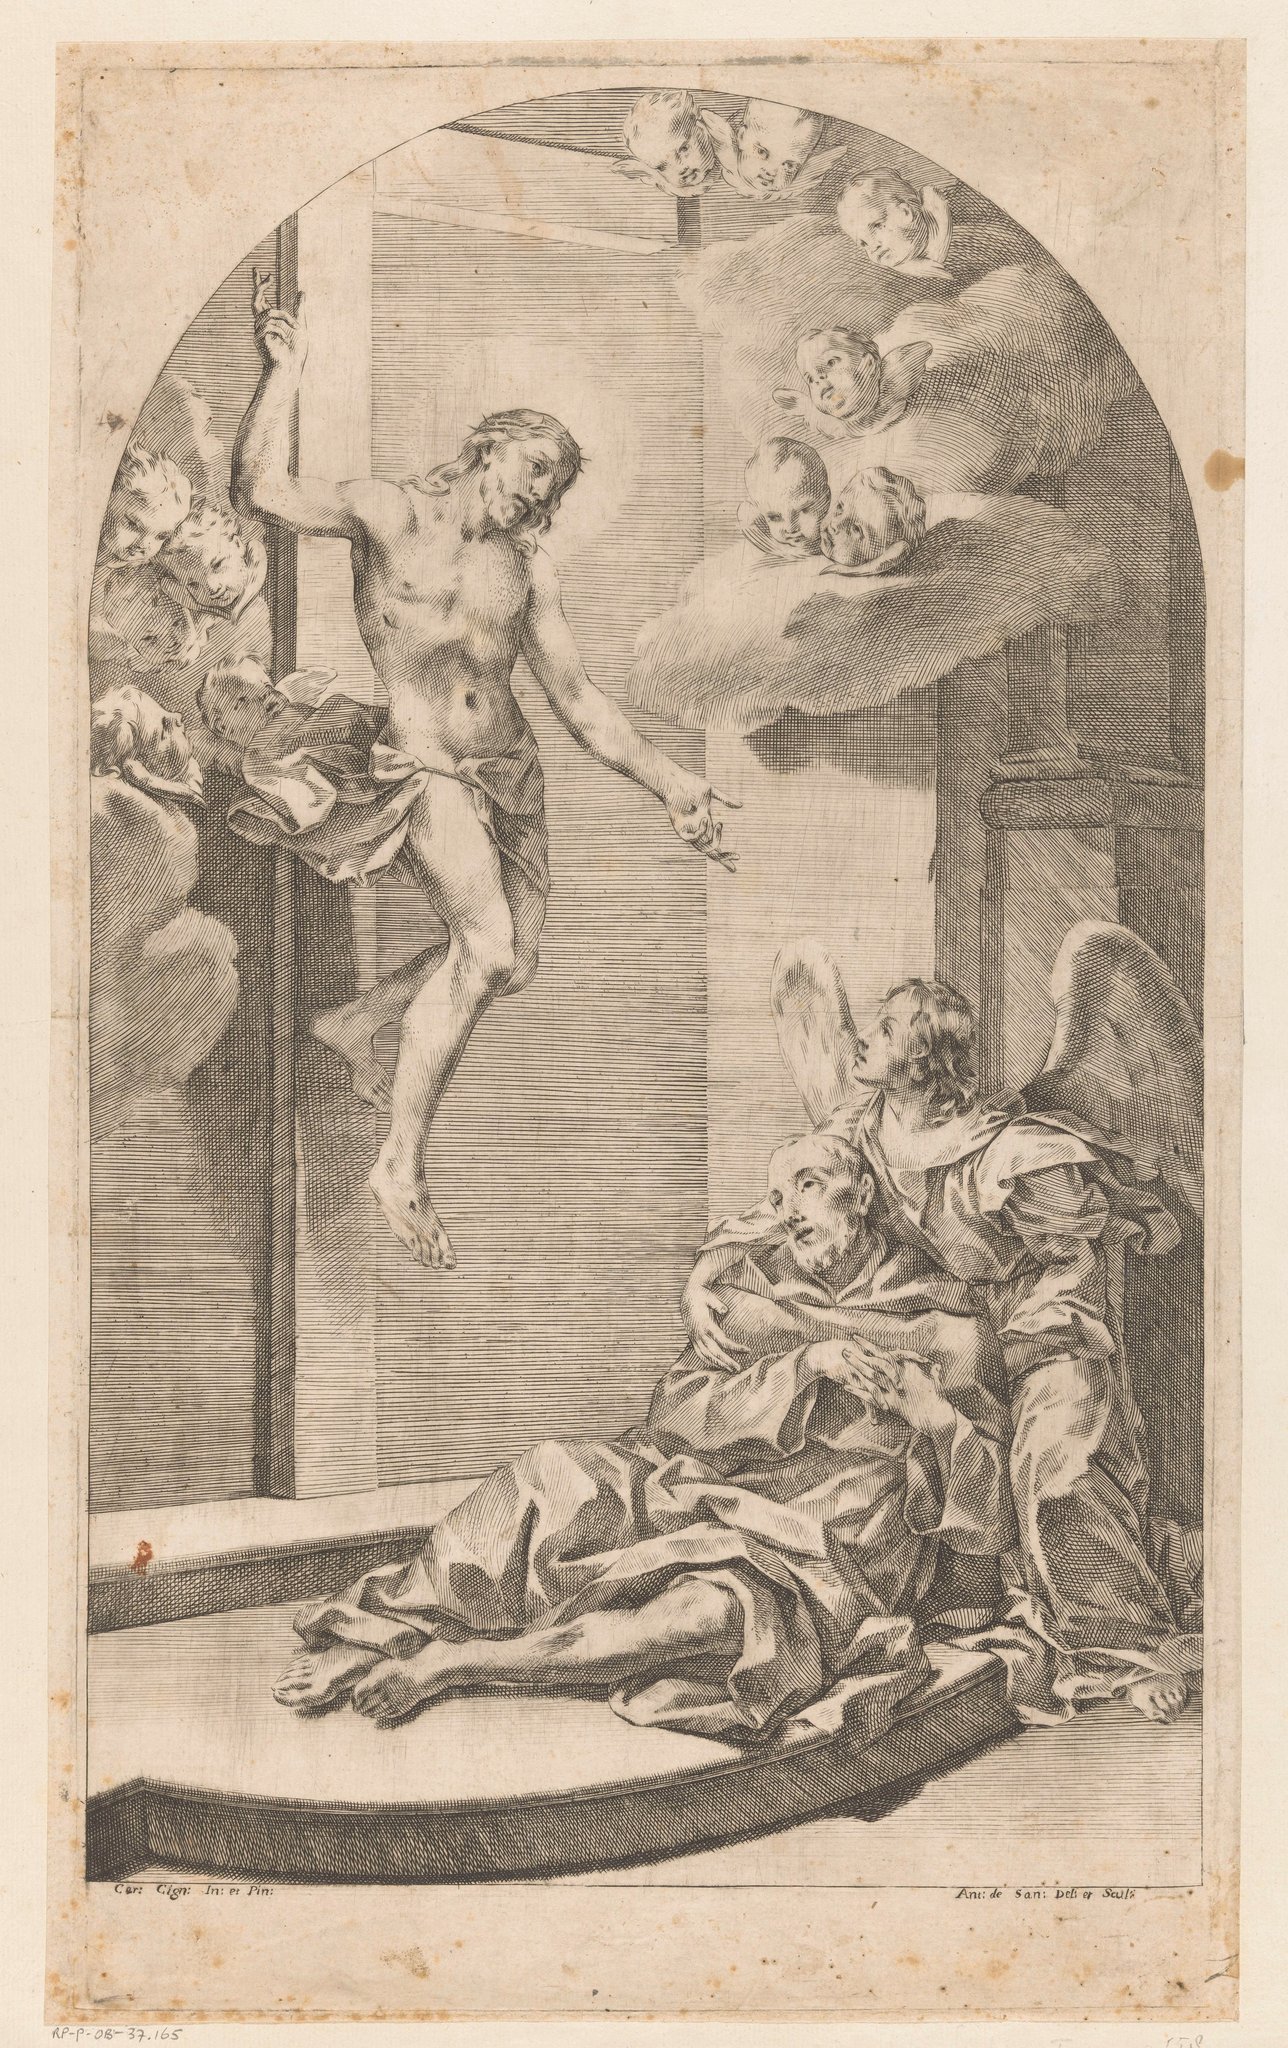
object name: print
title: Christus verschijnt aan geestelijke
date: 1600-1699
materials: paper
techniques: engraving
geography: italy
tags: (adult) christ appearing to mortals, cherubs, i.e. children's heads with wings, angels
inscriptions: collector's mark: Lugt 240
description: De dode Christus verschijnt aan een geestelijke. Christus zweeft in de lucht en wordt omringd door cherubijnen. De geestelijke ligt op de grond en wordt ondersteund door een engel.